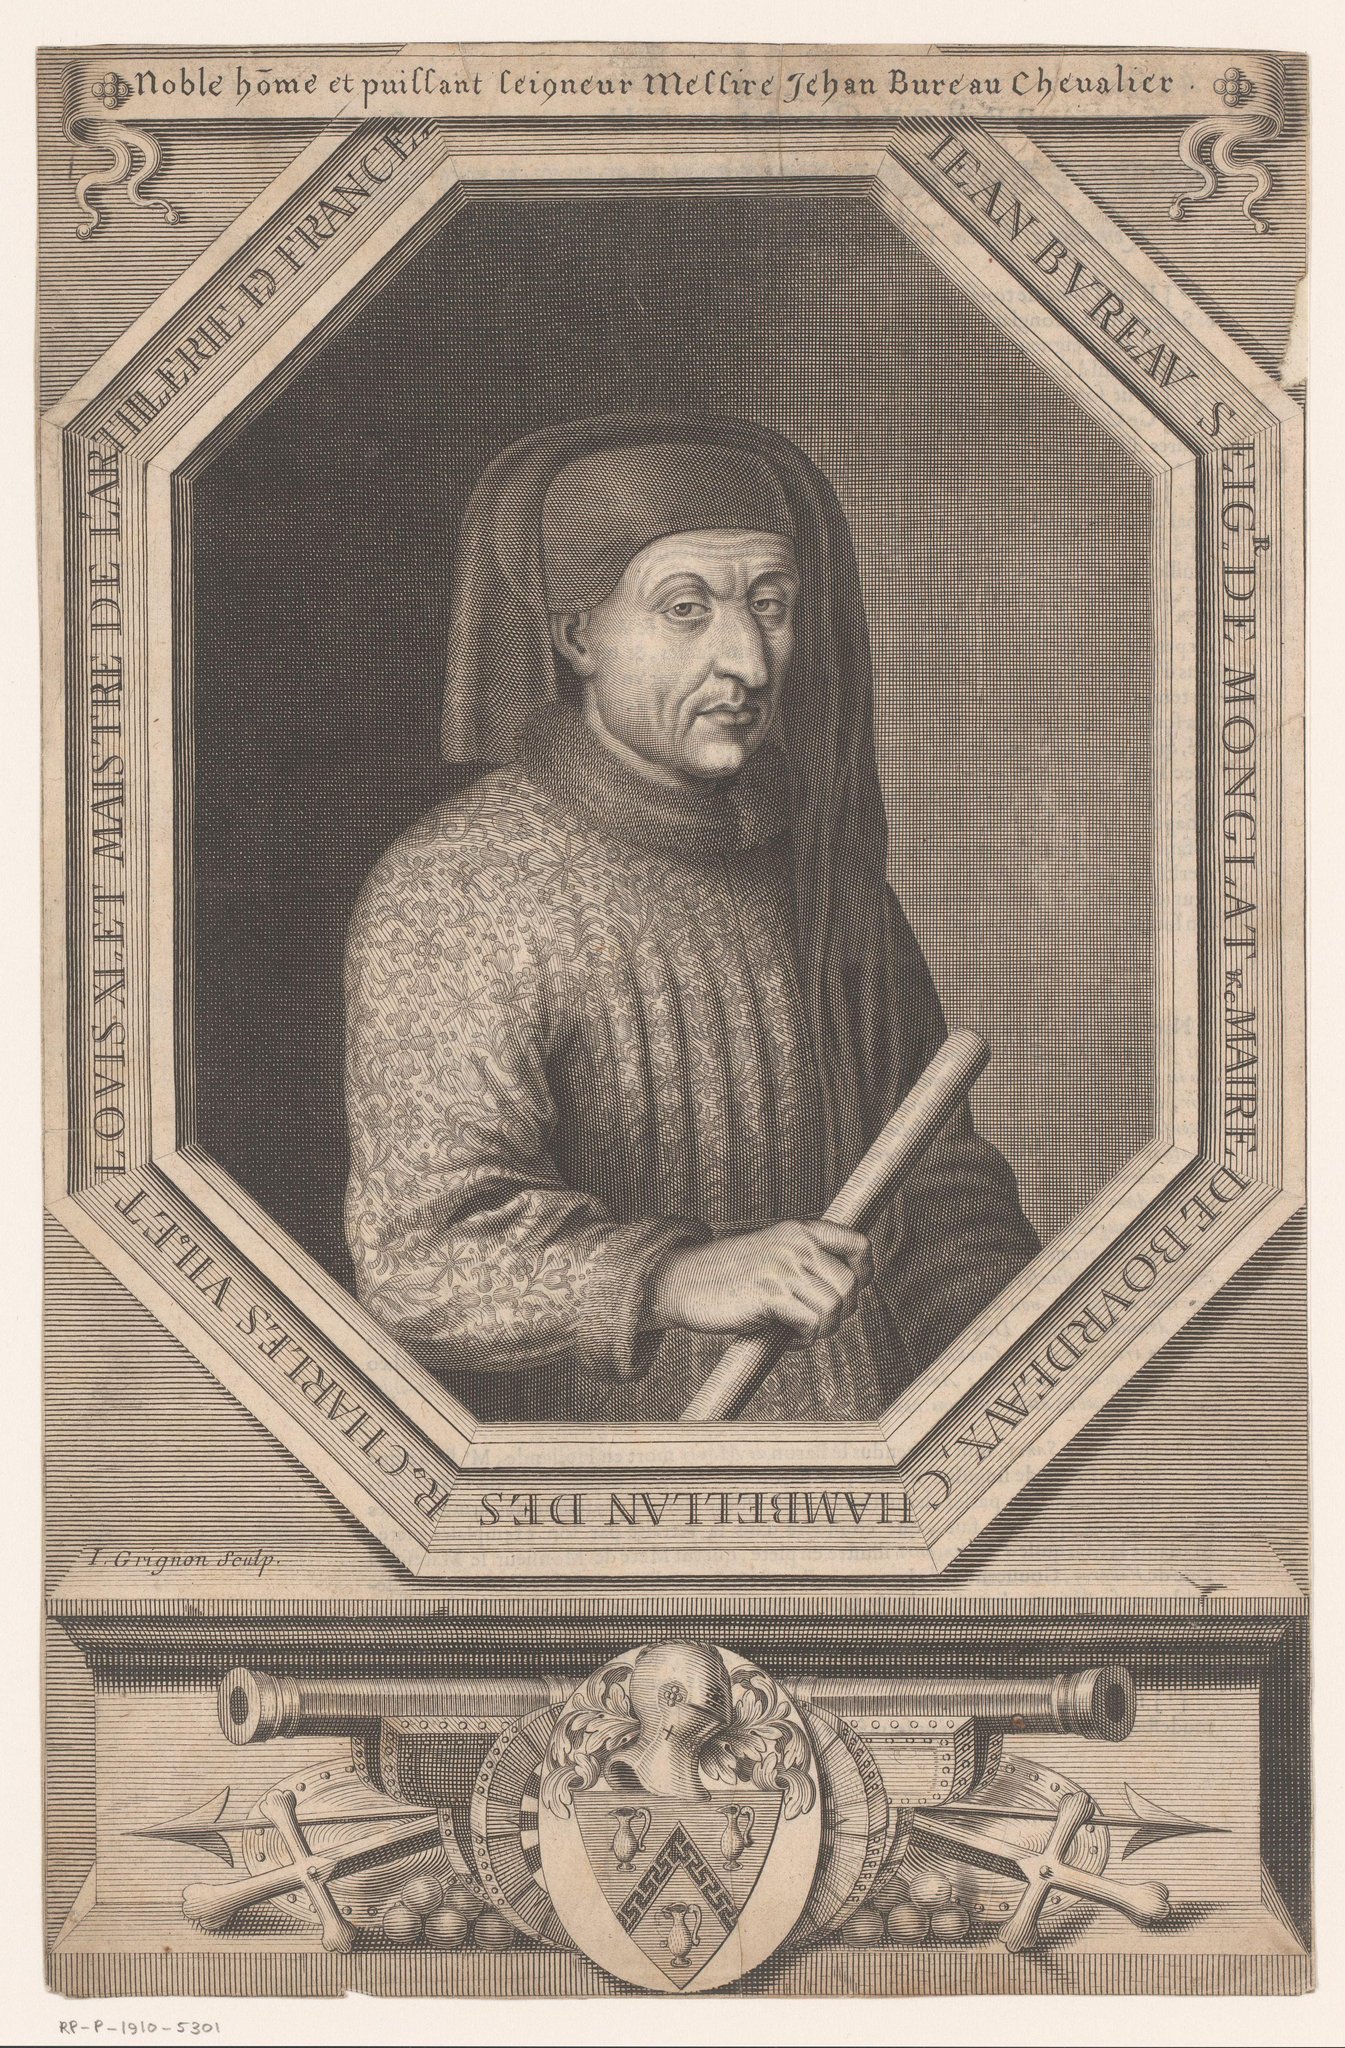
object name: book illustration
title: Portret van Jean Bureau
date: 1650-1689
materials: paper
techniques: engraving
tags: paris, commander-in-chief, general, marshal, historical persons, armorial bearing, heraldry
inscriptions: inscription: ‘44f =’, collector's mark: Lugt 2228